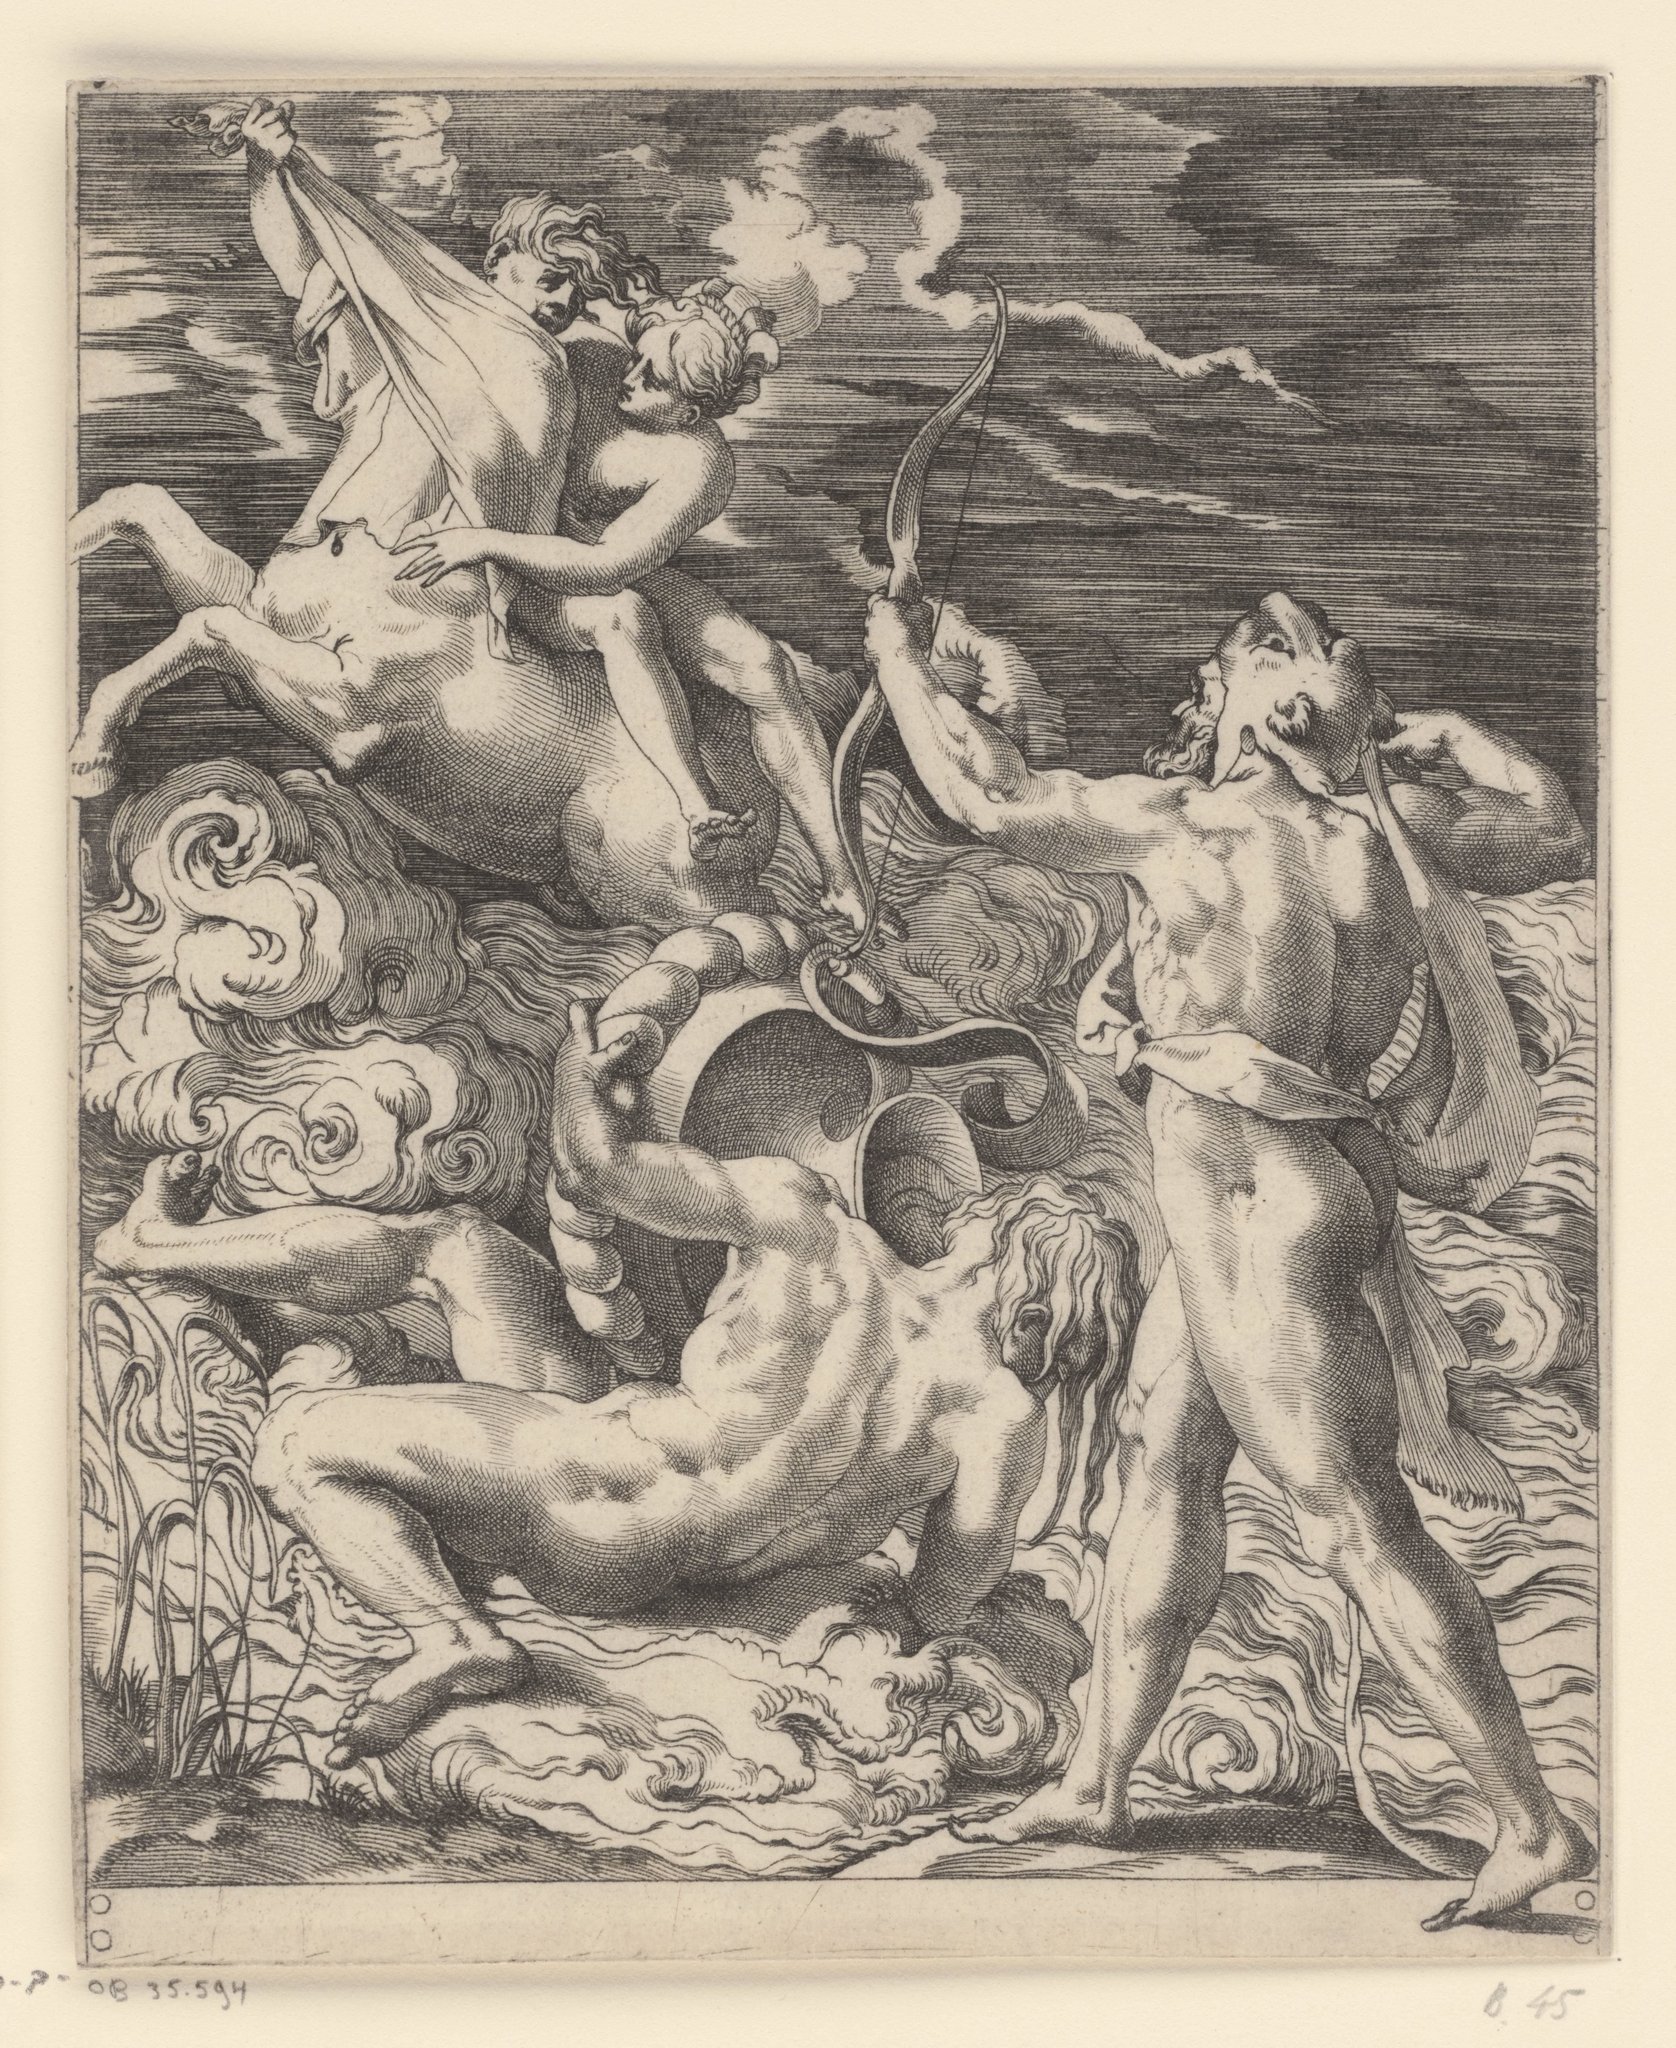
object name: print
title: Hercules doodt de centaur Nessus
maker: giovanni jacopo caraglio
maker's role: goldsmith, print maker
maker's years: 1500-1565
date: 1515-1565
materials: paper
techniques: engraving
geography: italy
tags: hercules shoots nessus, the centaur, who attempts to carry off deianira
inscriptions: collector's mark: Lugt 240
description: De centaur Nessus is veerman bij een rivier. Als hij Deïanira overzet, probeert hij haar te roven en galoppeert hij met haar weg. Hercules die al op de andere oever stond, spant zijn boog om Nessus neer te schieten.